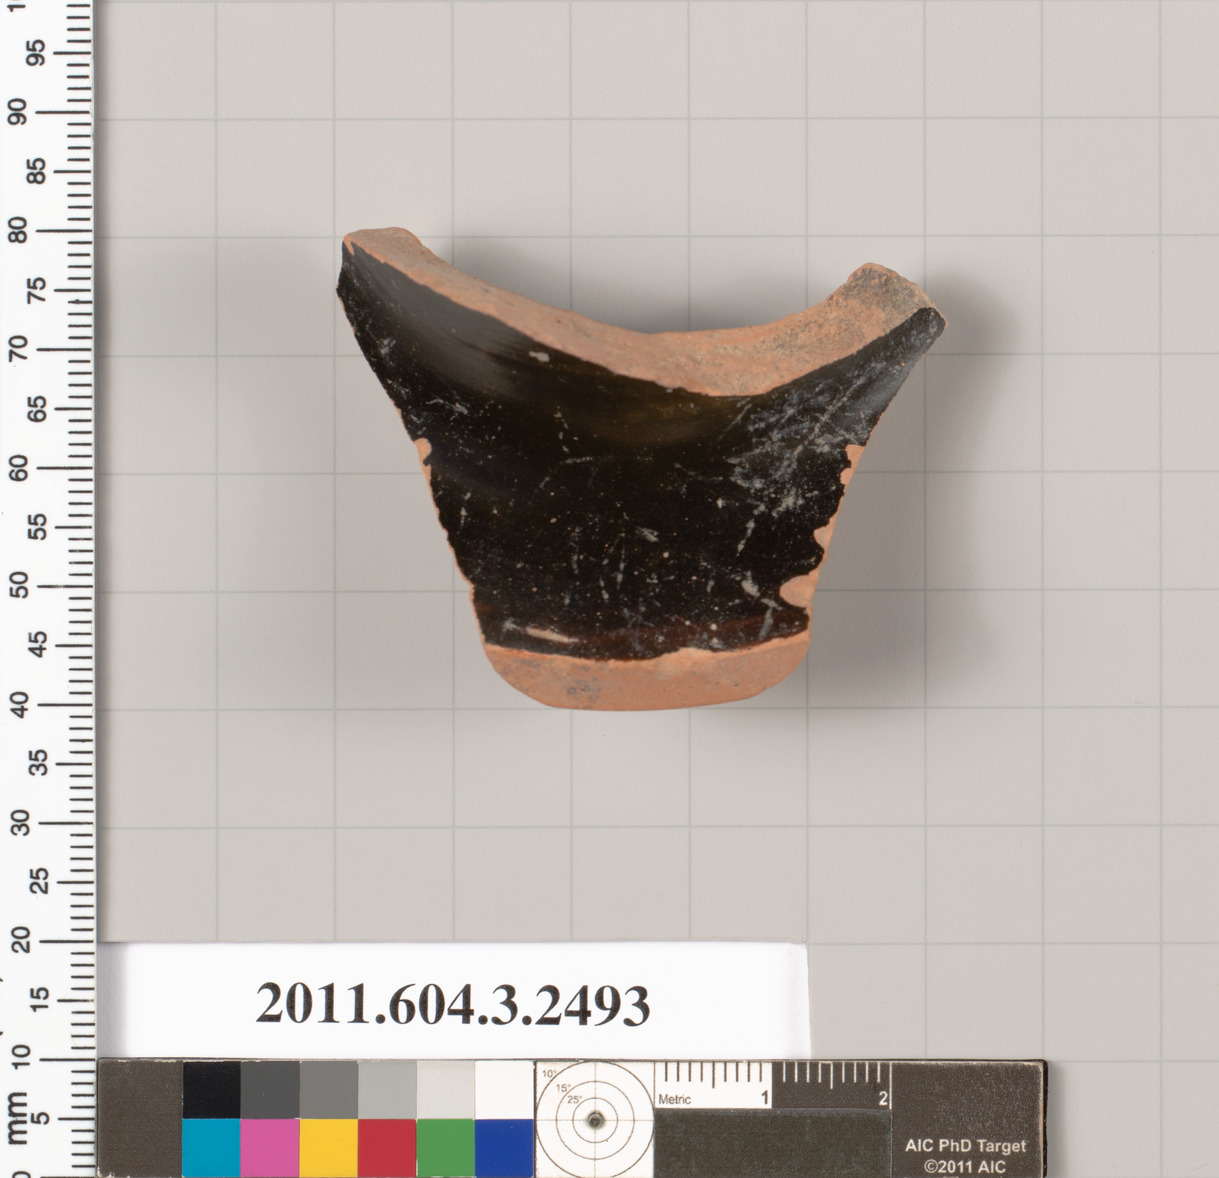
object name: kylix fragment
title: Terracotta fragment of a kylix (drinking cup)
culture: greek, attic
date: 600-401 BCE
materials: terracotta